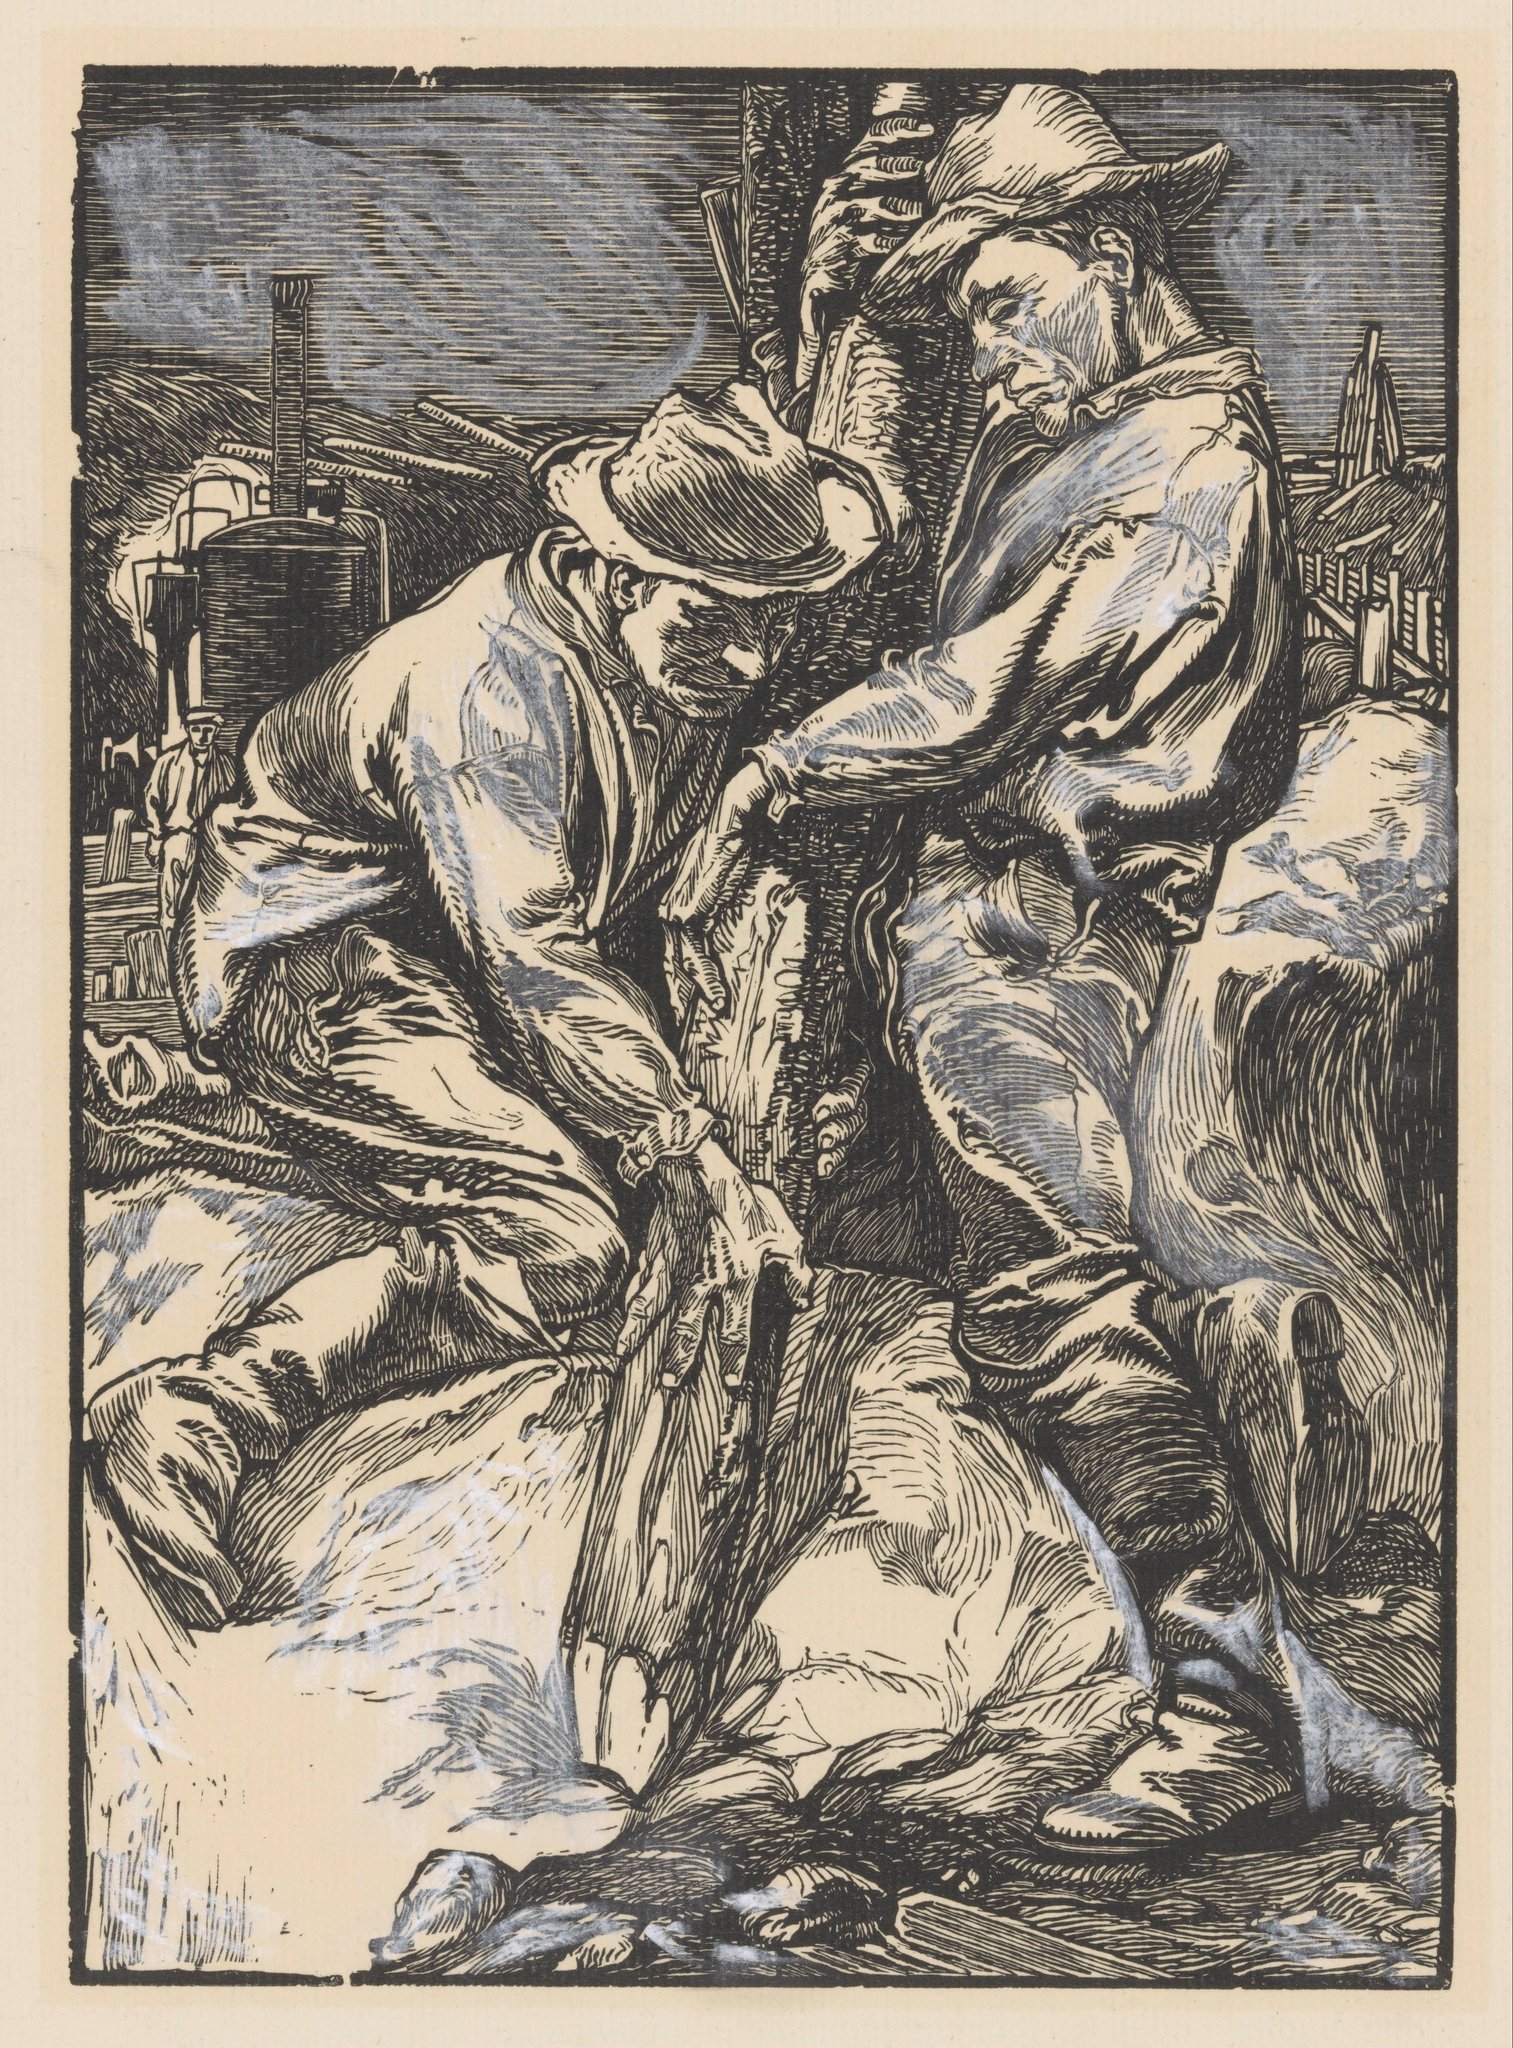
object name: print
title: Bouwarbeiders bezig met heiwerk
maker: johannes josephus aarts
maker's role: draughtsman, print maker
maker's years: 1871-1934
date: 1881-1934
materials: chalk, paper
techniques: woodcut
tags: ramming, driving piles (~ building activities), working class, labourers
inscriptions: collector's mark: Lugt 2166, collector's mark: Lugt 2760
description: Twee arbeiders plaatsen samen een paal in de grond. Ze dragen beiden een hoed. Linksachter hen een machine en een andere arbeider.